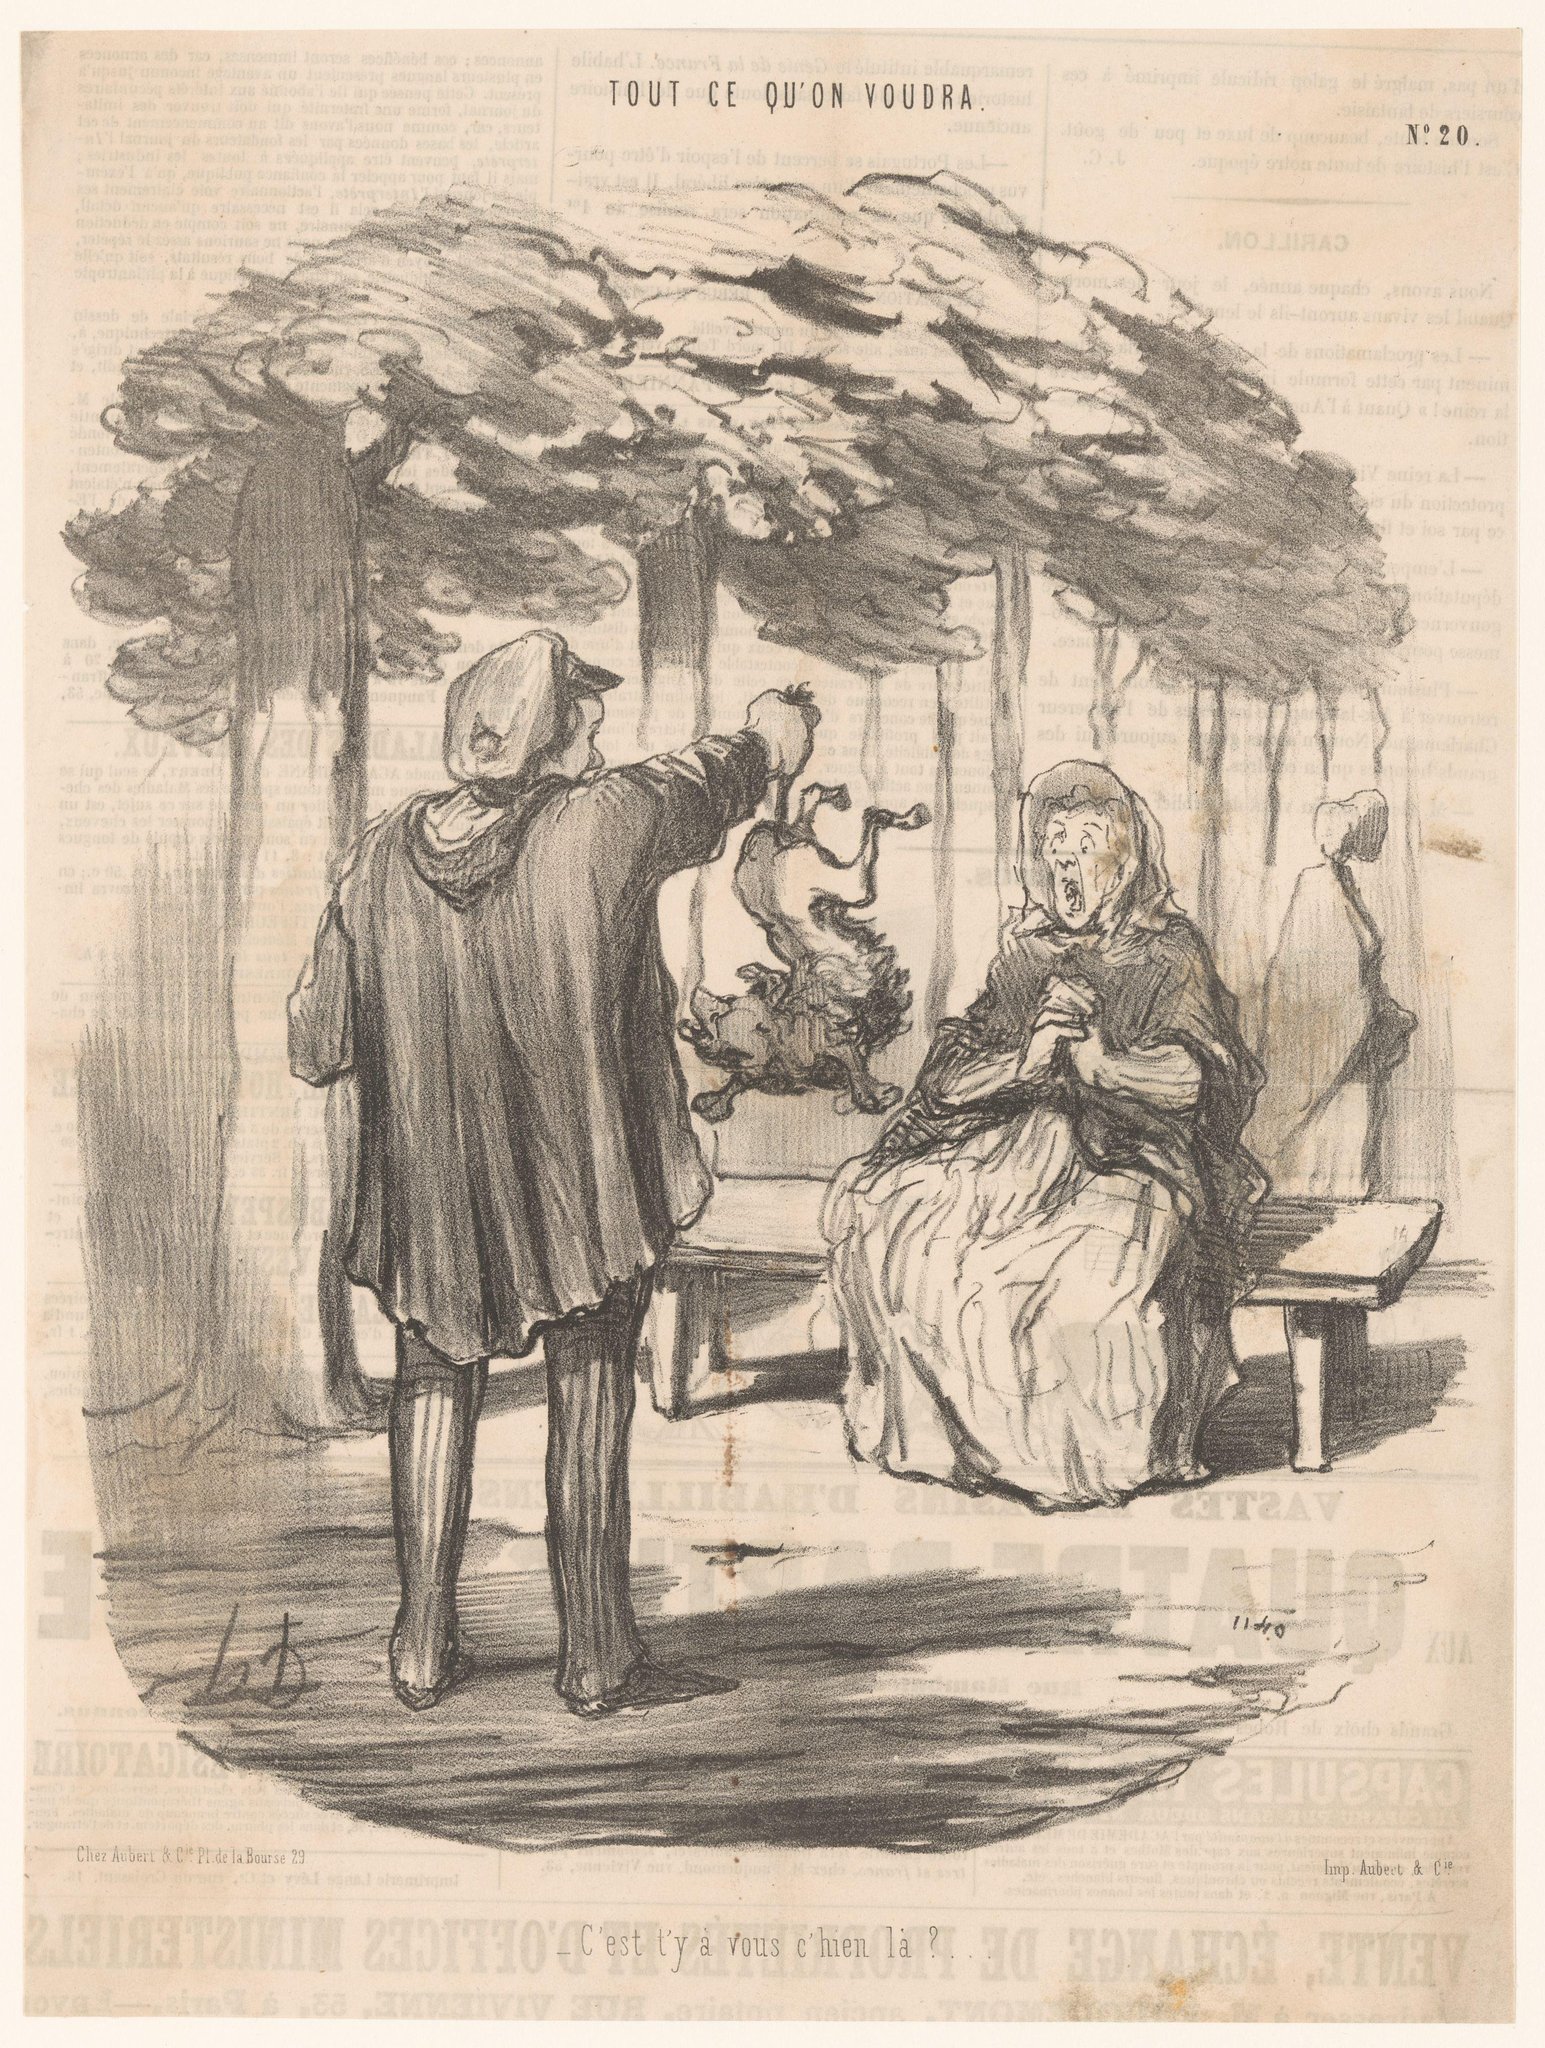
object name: cartoon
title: Wenselijke en onwenselijke situaties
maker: honoré daumier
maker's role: draughtsman, painter, print maker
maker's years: 1808-1879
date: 1847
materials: paper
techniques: lithograph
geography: paris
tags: caricatures (human types), old woman, dog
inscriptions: collector's mark: Lugt 2228a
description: Prent gebruikt voor: Le Charivari, 4 november 1847.